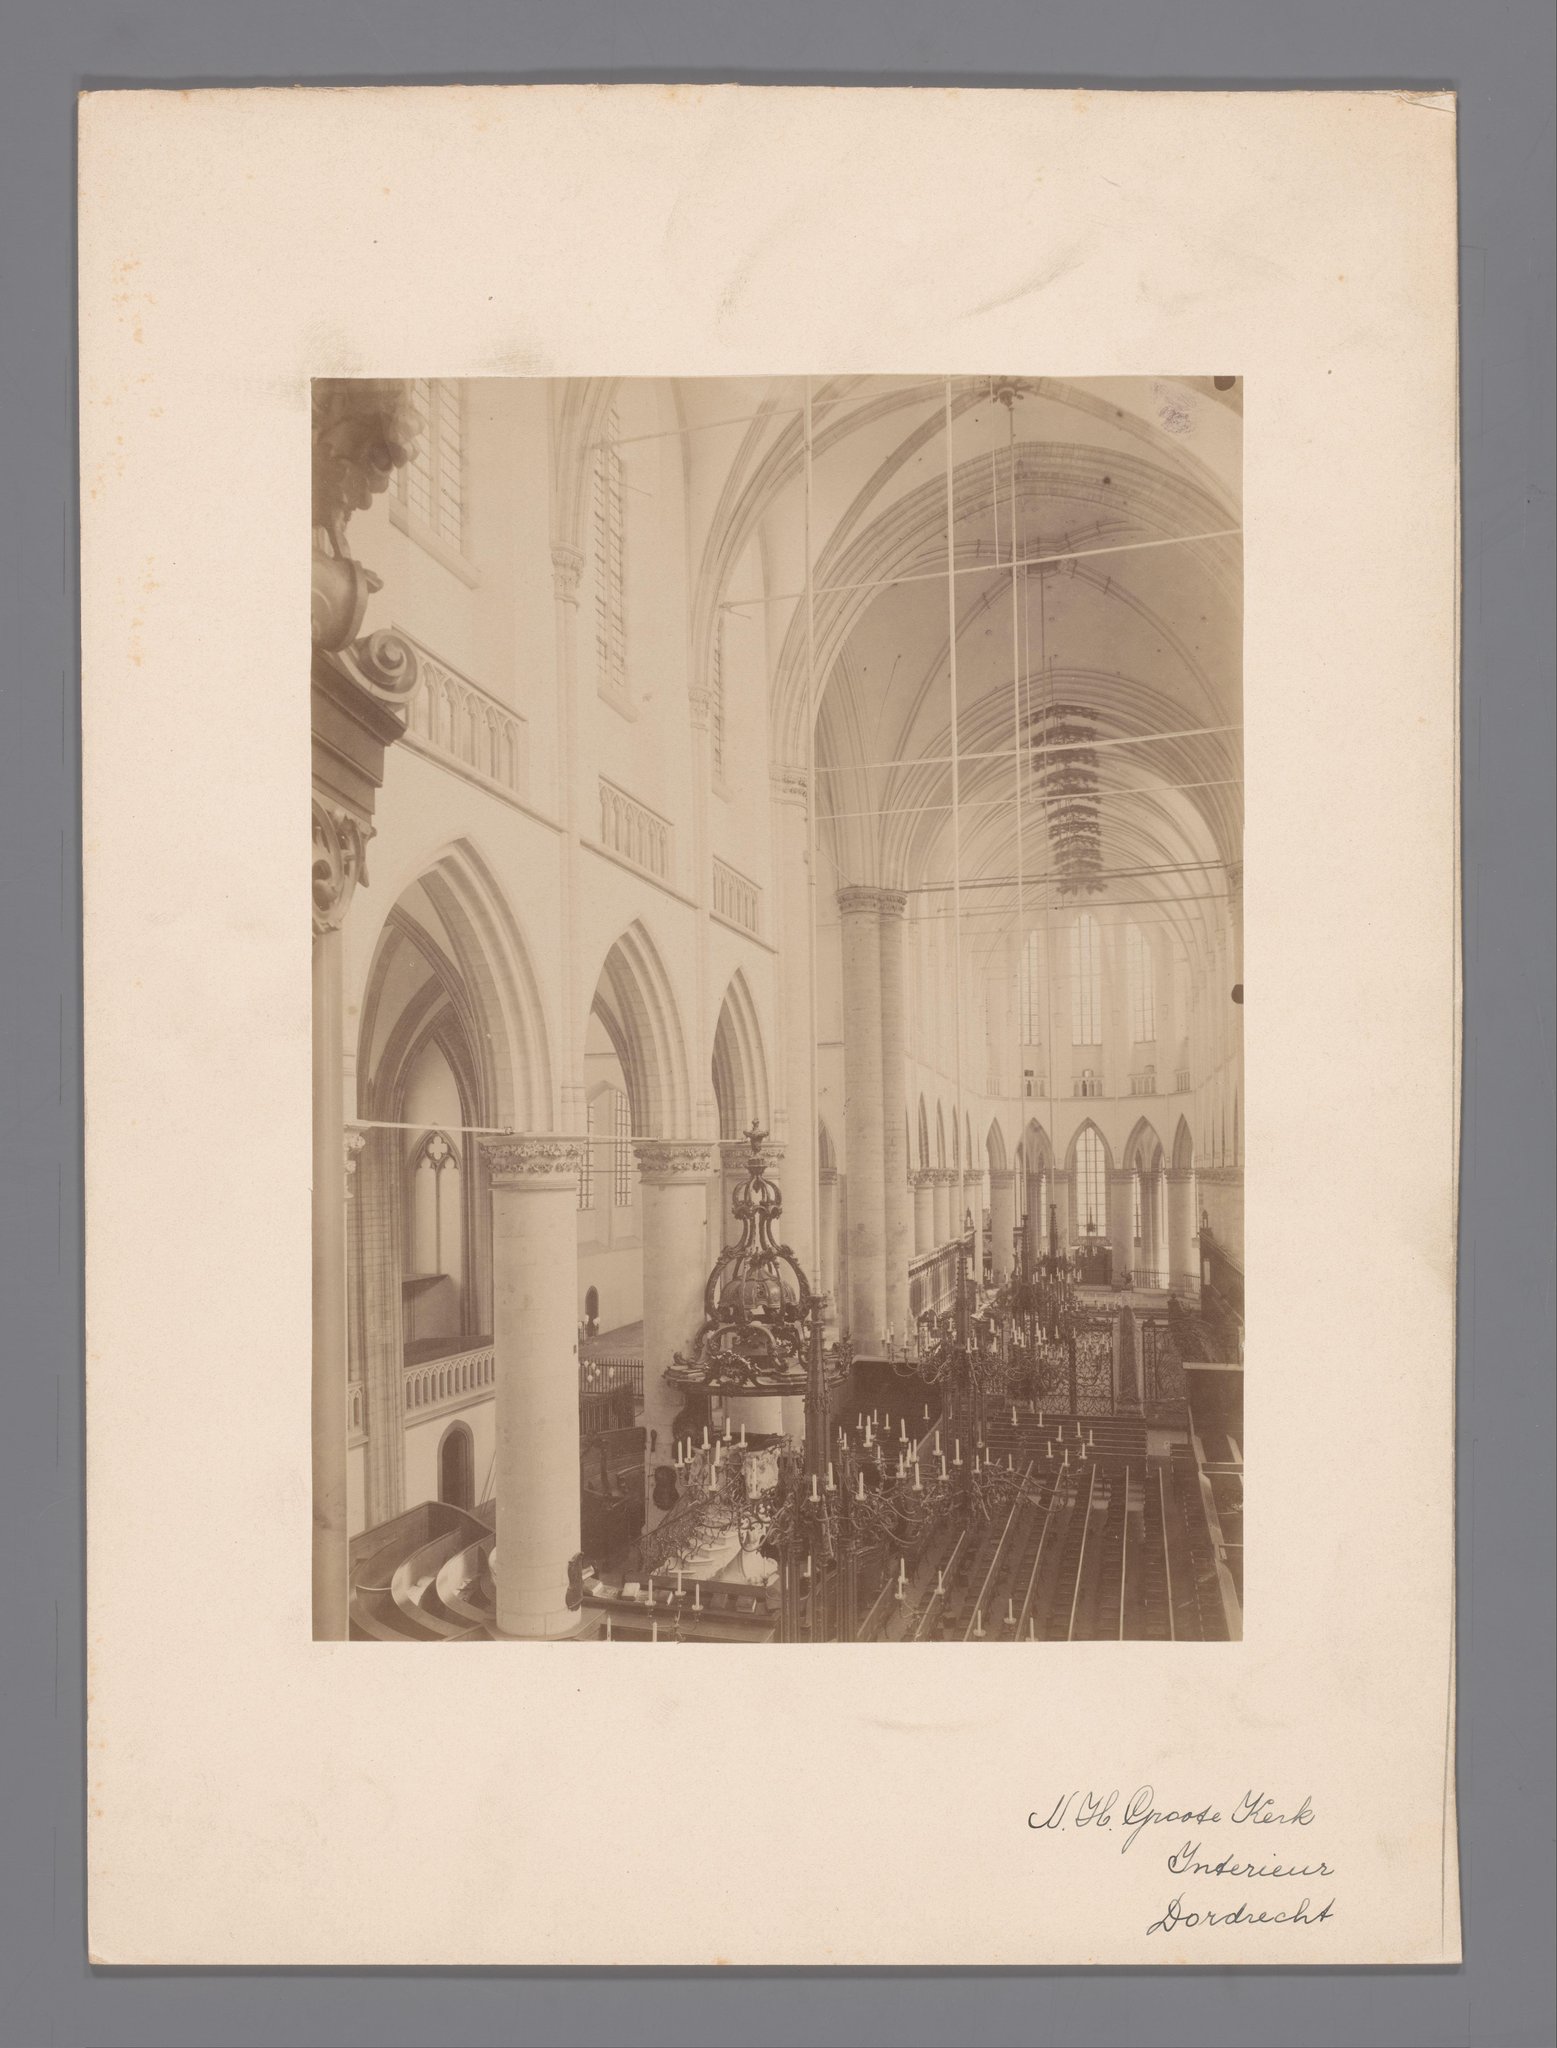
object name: photograph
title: Interieur van de Grote of Onze-Lieve-Vrouwenkerk te Dordrecht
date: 1880-1910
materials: cardboard, photographic support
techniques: albumen print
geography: grote of onze-lieve-vrouwekerk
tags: interior of church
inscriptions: annotation: ‘Dordrecht (Z.H.)/ Het interieur der kerk’, annotation: ‘N.H. Groote Kerk/ Inteieur/ Dordrecht’